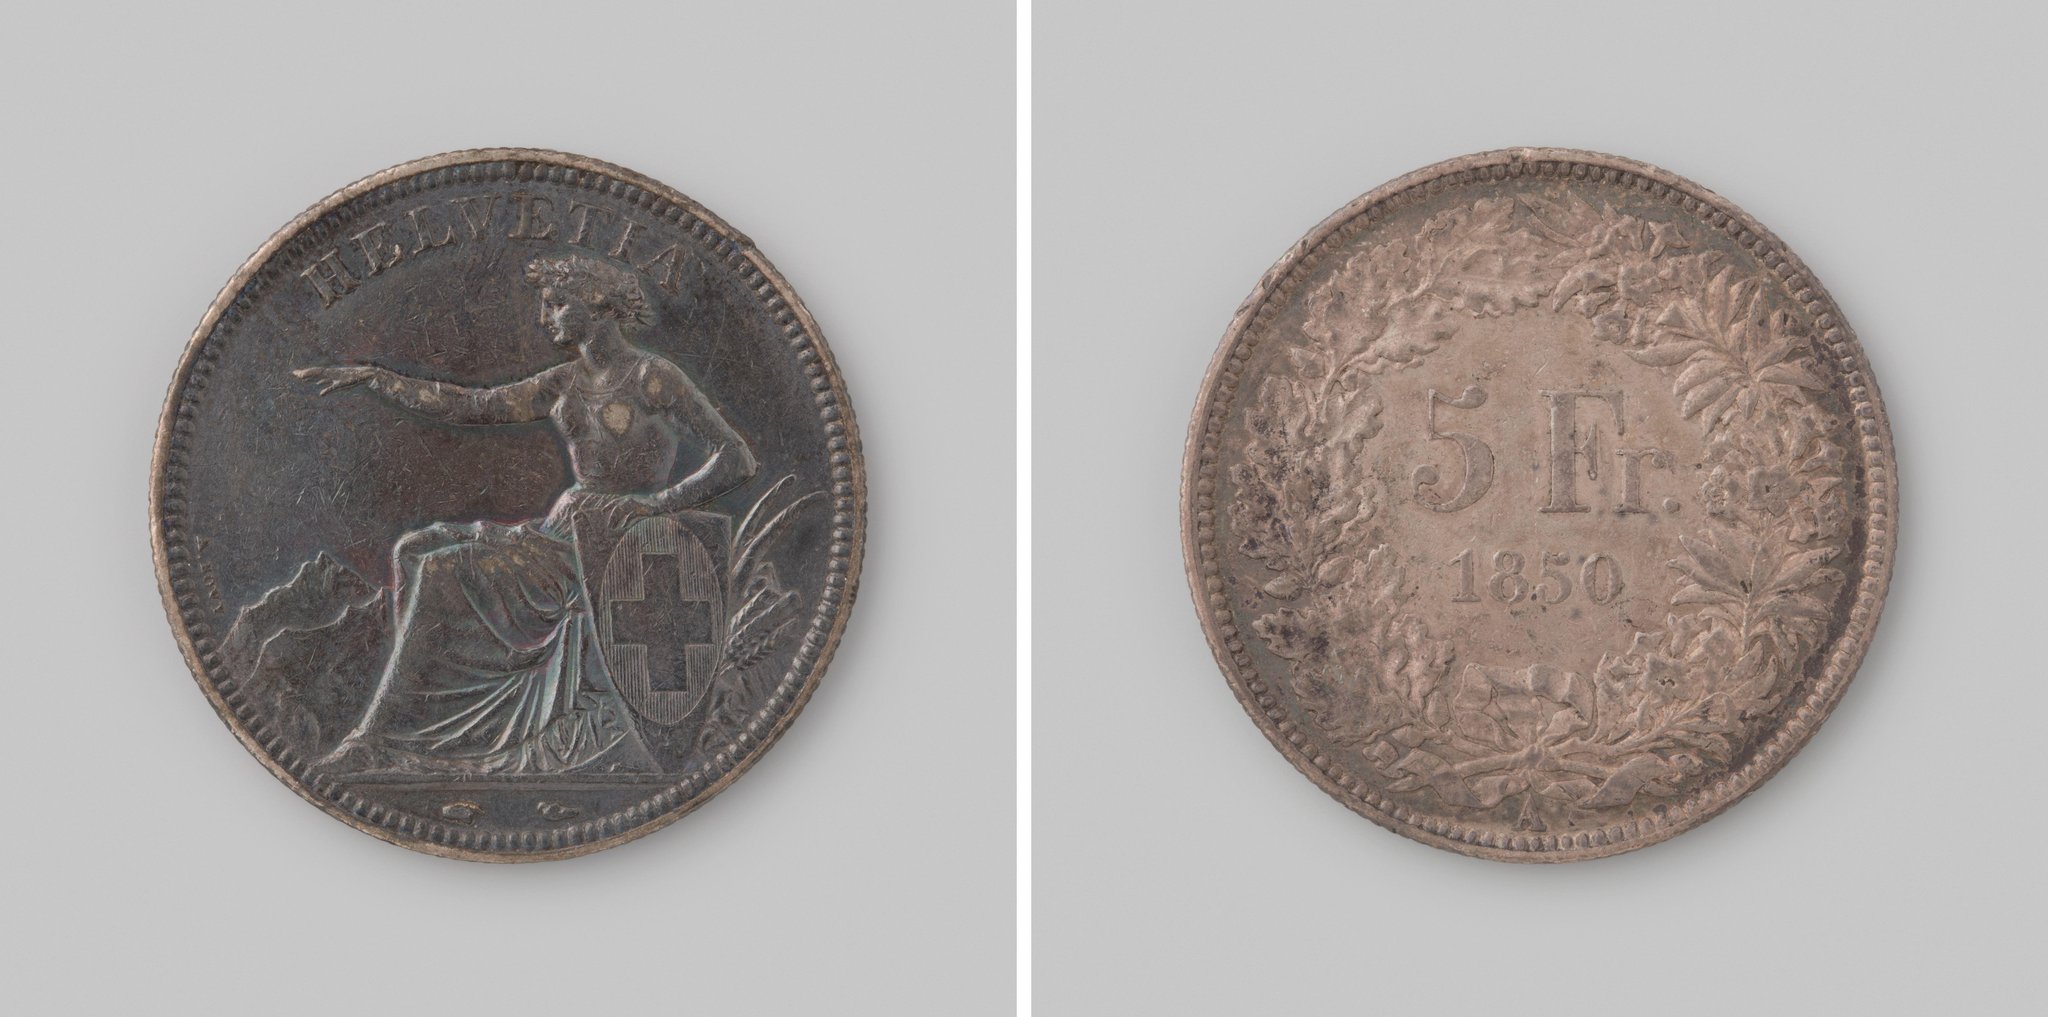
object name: coin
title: Zwitserland, 5 franken, 1850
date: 1850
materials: silver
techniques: striking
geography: paris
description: Zilveren munt. Voorzijde: Helvetia zittend met het wapenschild van Zwitserland tegen een achtergrond van bergen. Keerzijde: binnen twee samengebonden takken in een regel waarde-aanduiding: 5 Fr., waaronder jaartal. Onderaan letter A [=Parijs]. Kartelrand.